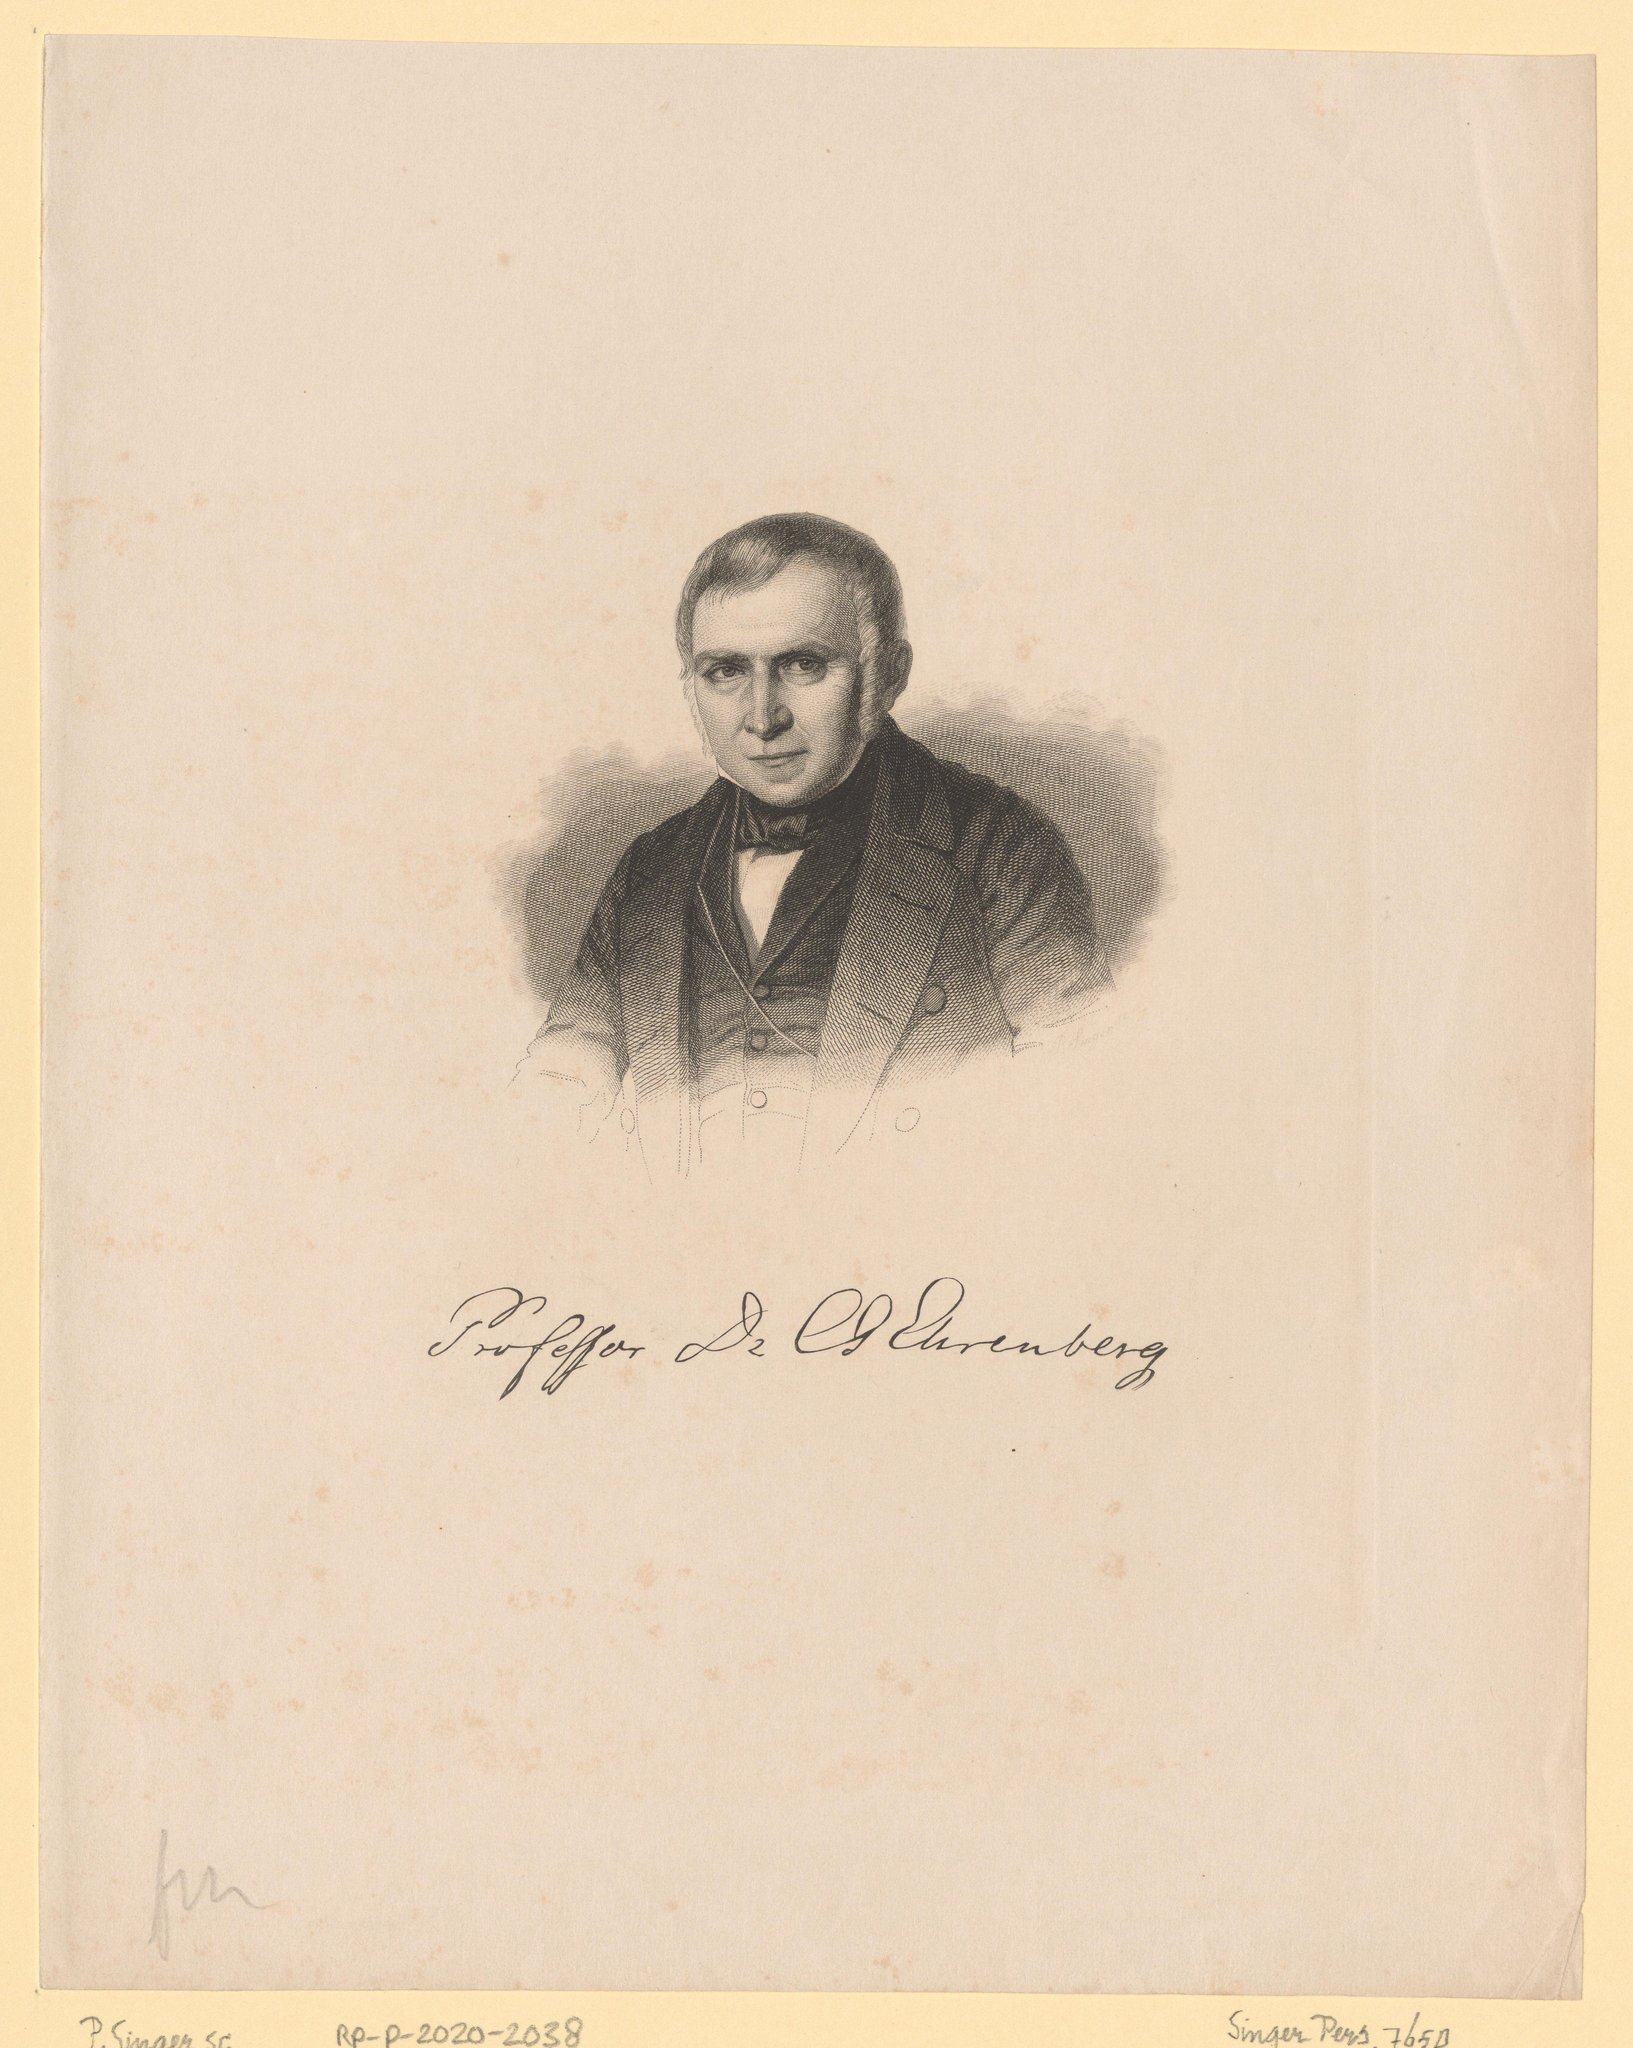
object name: print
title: Portret van Christian Gottfried Ehrenberg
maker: p. singer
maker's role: print maker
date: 1835-1890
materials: paper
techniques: engraving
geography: germany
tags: berlin, zoology (+ portrait of scholar, scientist), historical persons